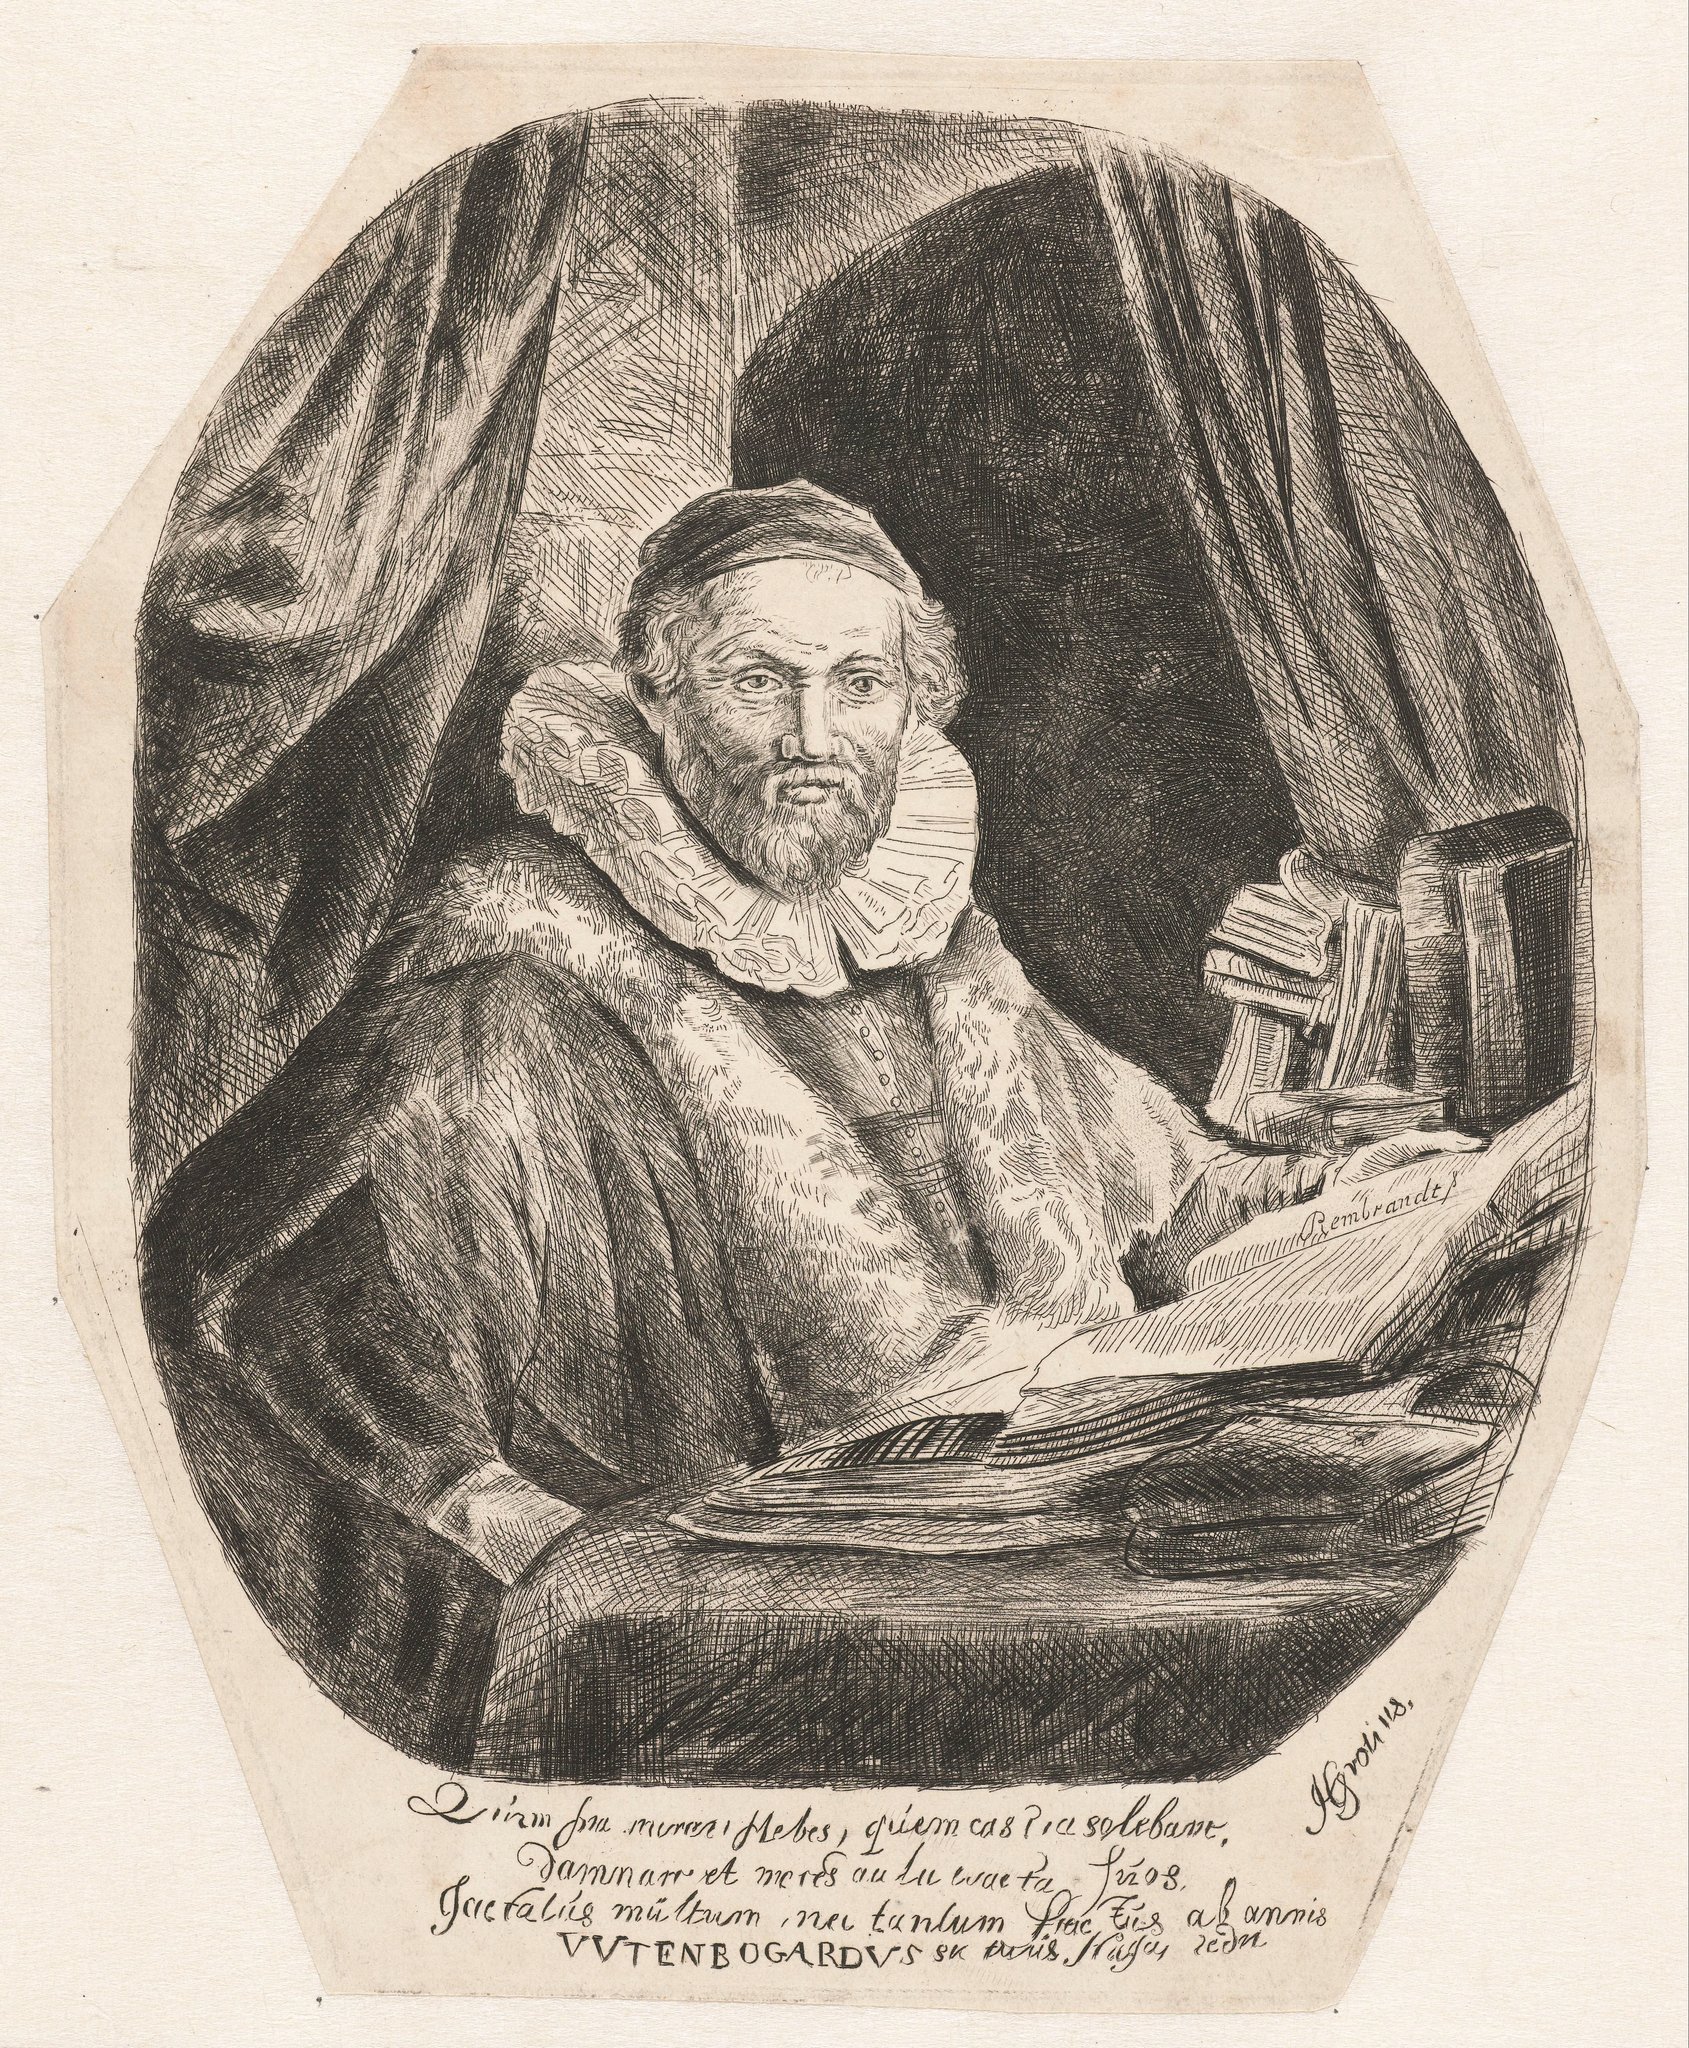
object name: print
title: Jan Uytenbogaert, preacher of the Remonstrants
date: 1635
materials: paper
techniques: etching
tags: the hague, historical persons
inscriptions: collector's mark: Lugt 2760, collector's mark: Lugt 2228